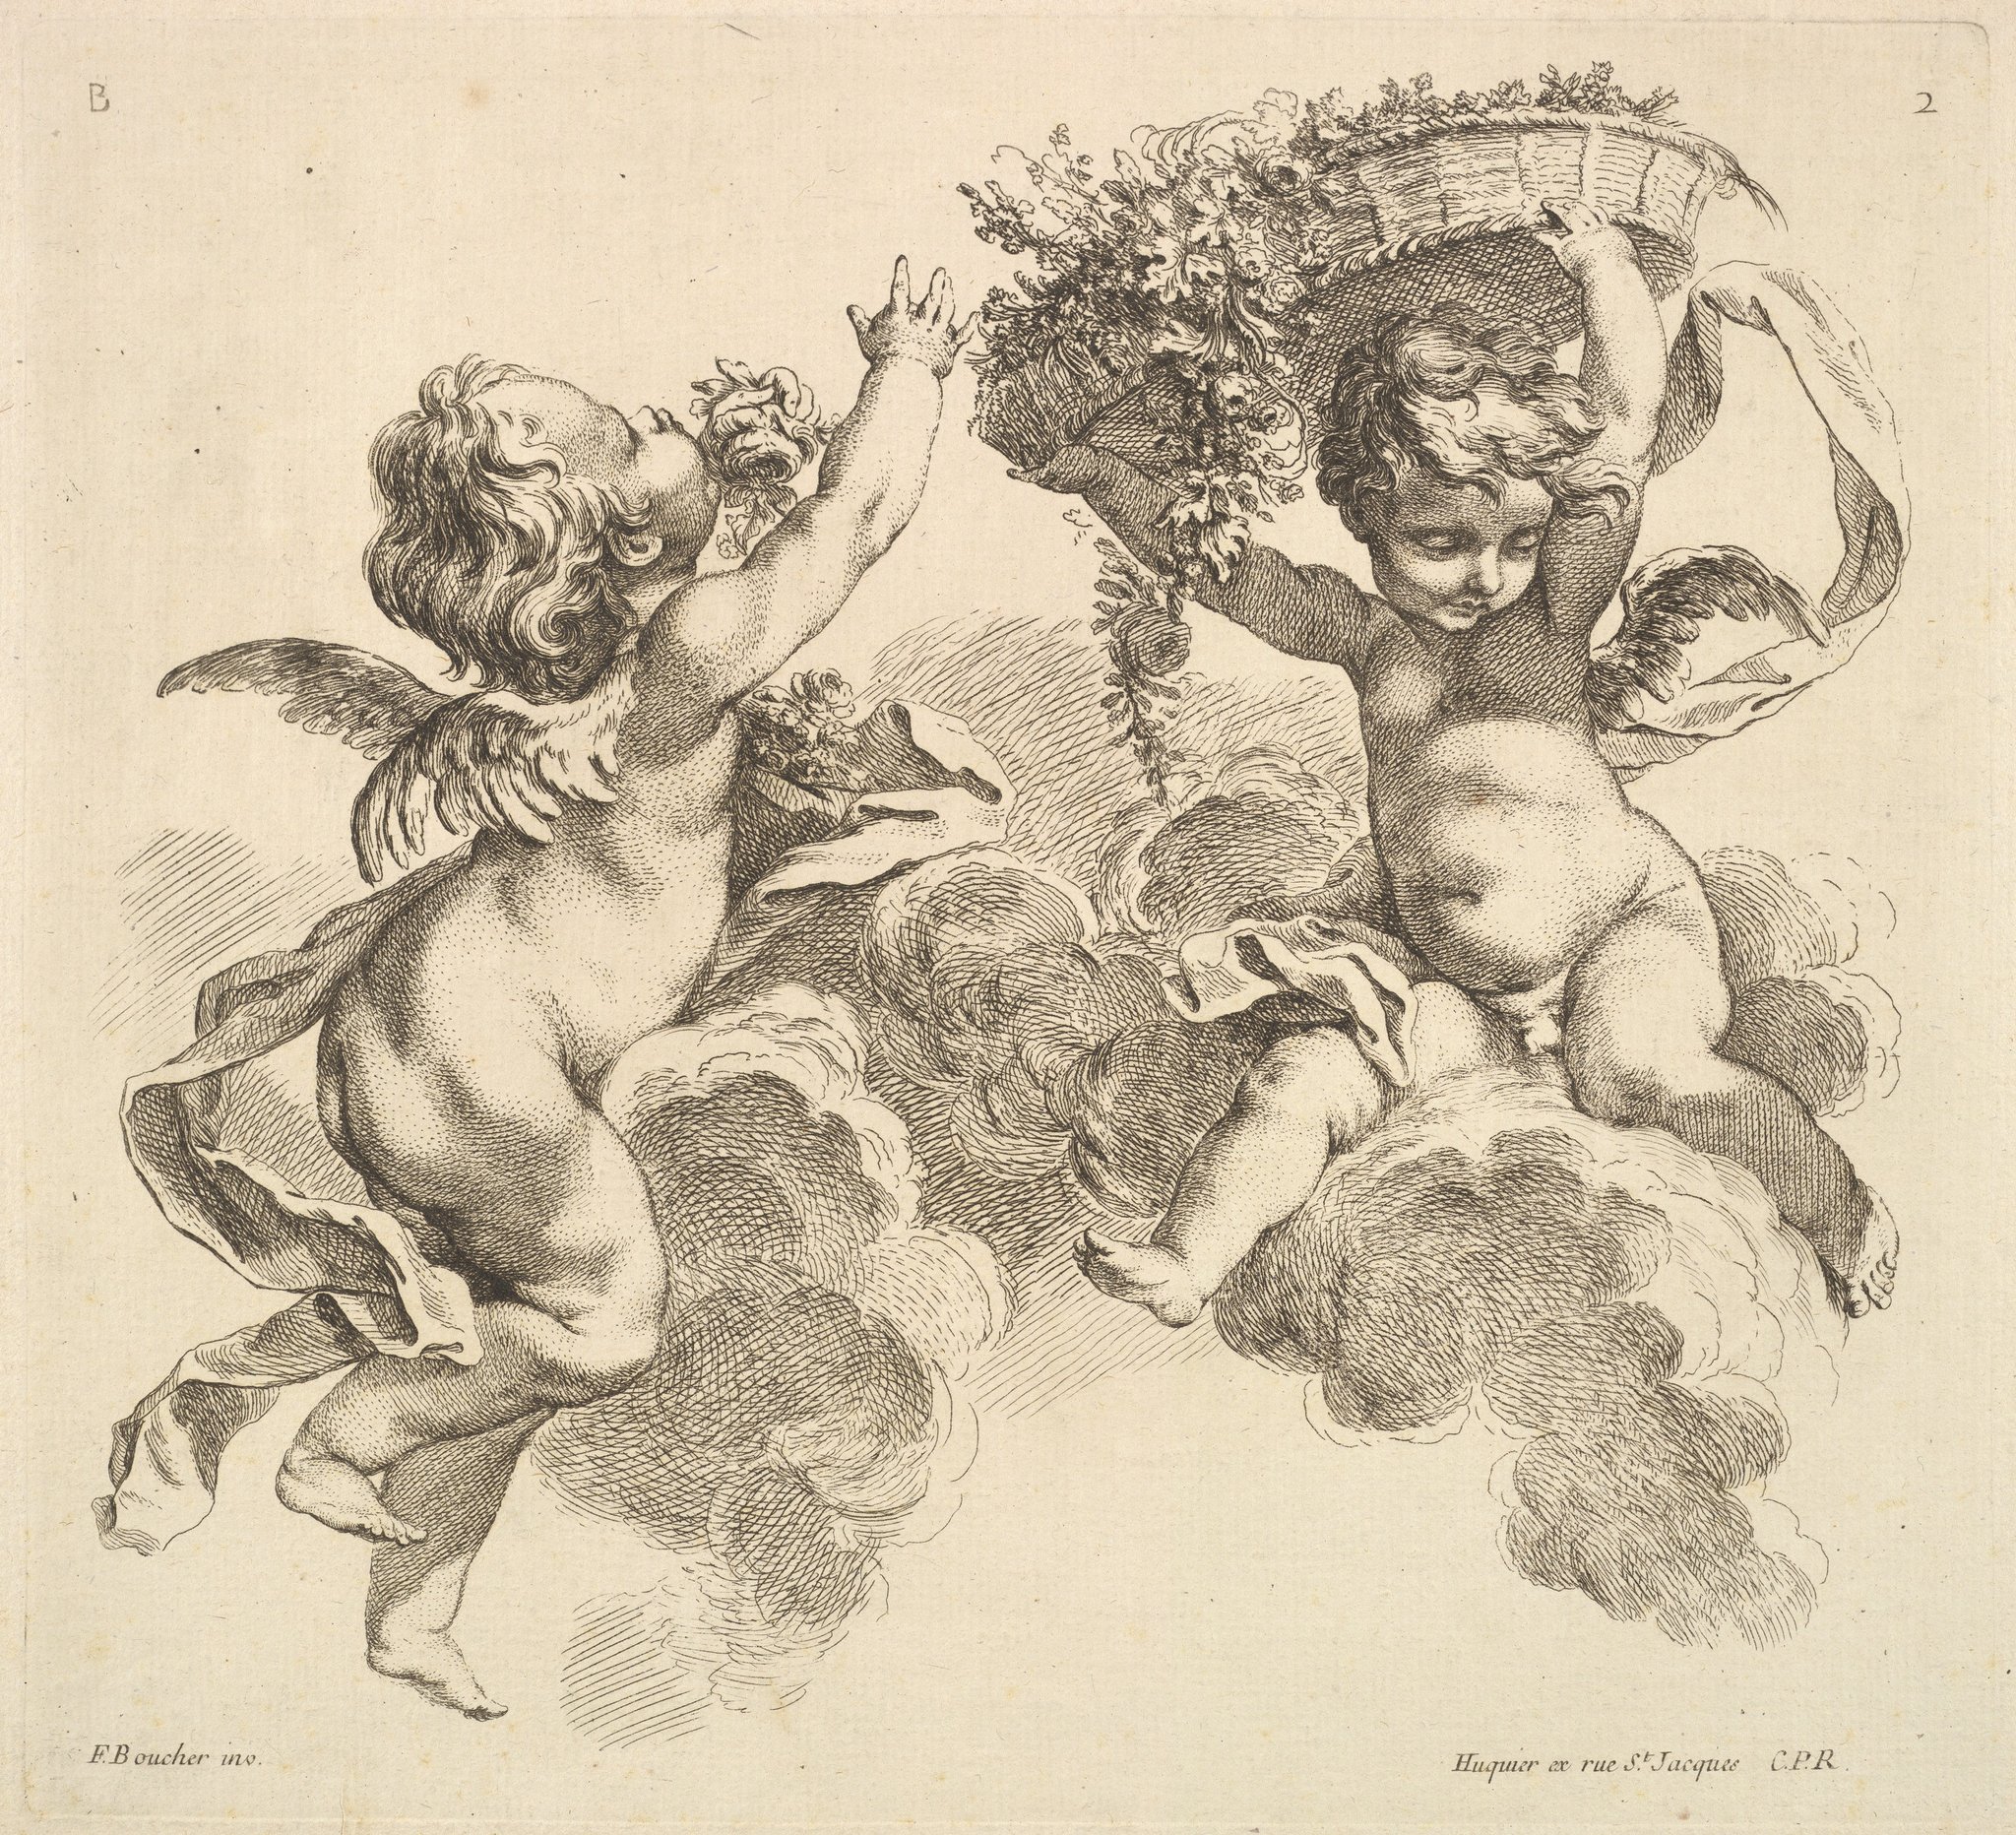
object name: print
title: Two Children, One Holding a Basket with Flowers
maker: gabriel huquier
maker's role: artist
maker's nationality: french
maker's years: 1695-1772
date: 1738-1745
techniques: engraving, etching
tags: flowers